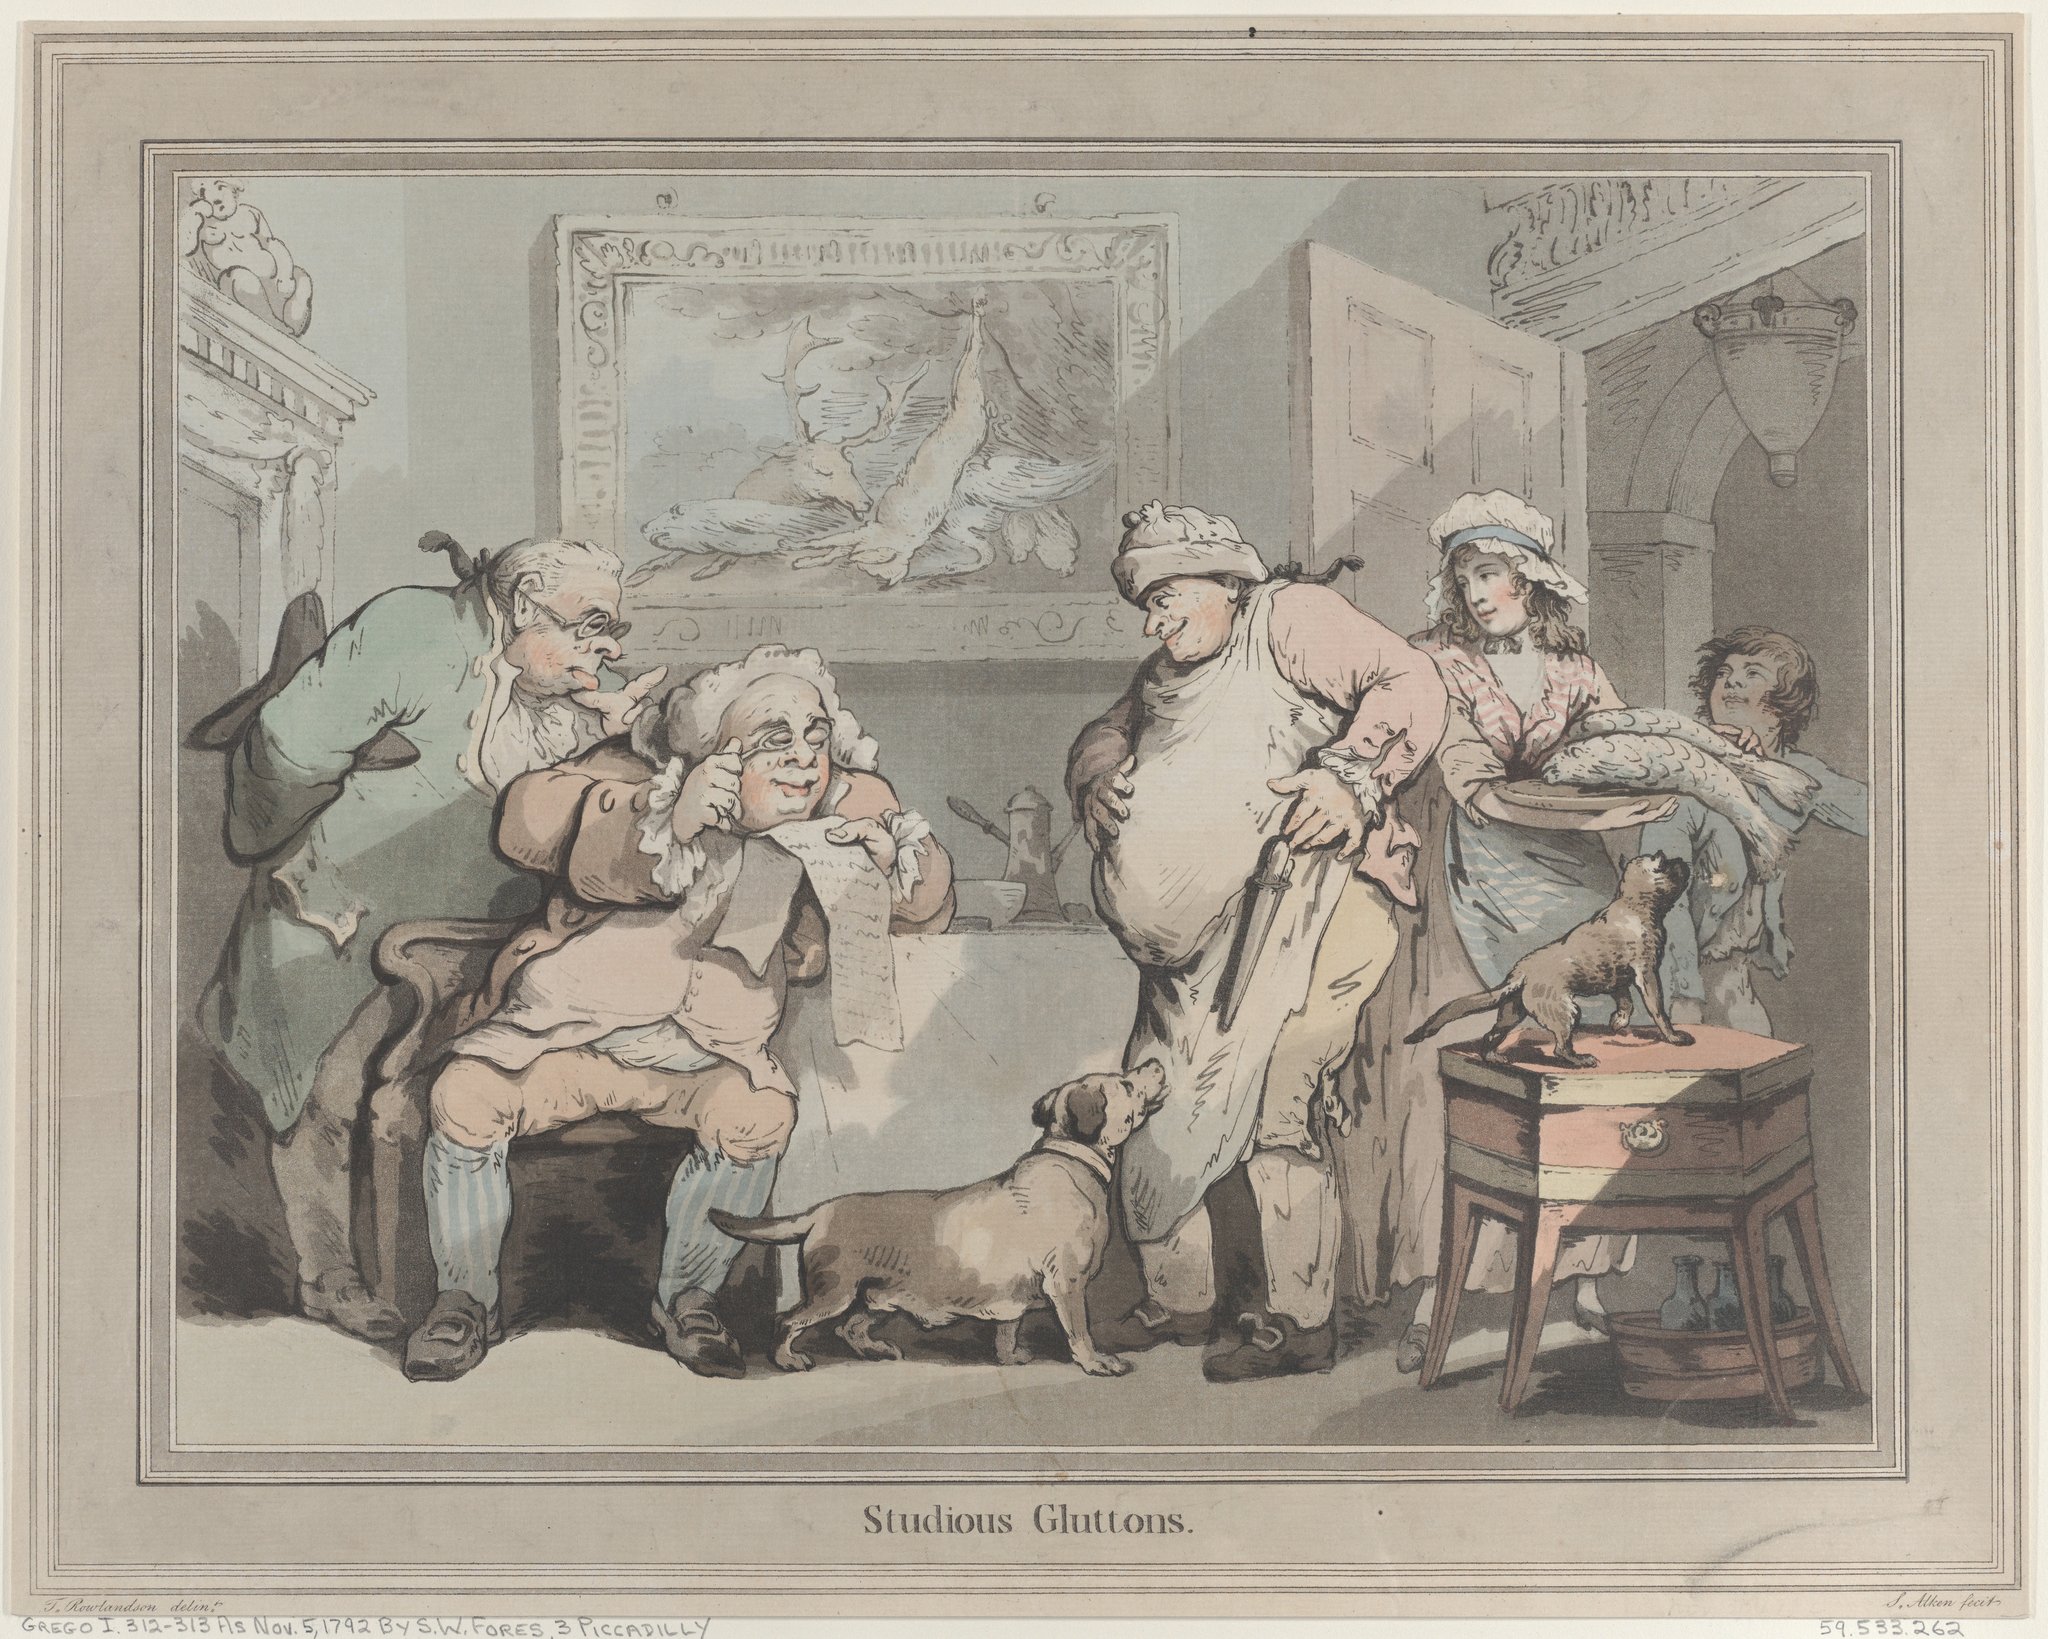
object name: print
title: Studious Gluttons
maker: samuel alken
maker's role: artist and publisher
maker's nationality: british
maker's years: 1756-1815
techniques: aquatint, etching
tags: satire,men,women,reading,cats,dogs,fish